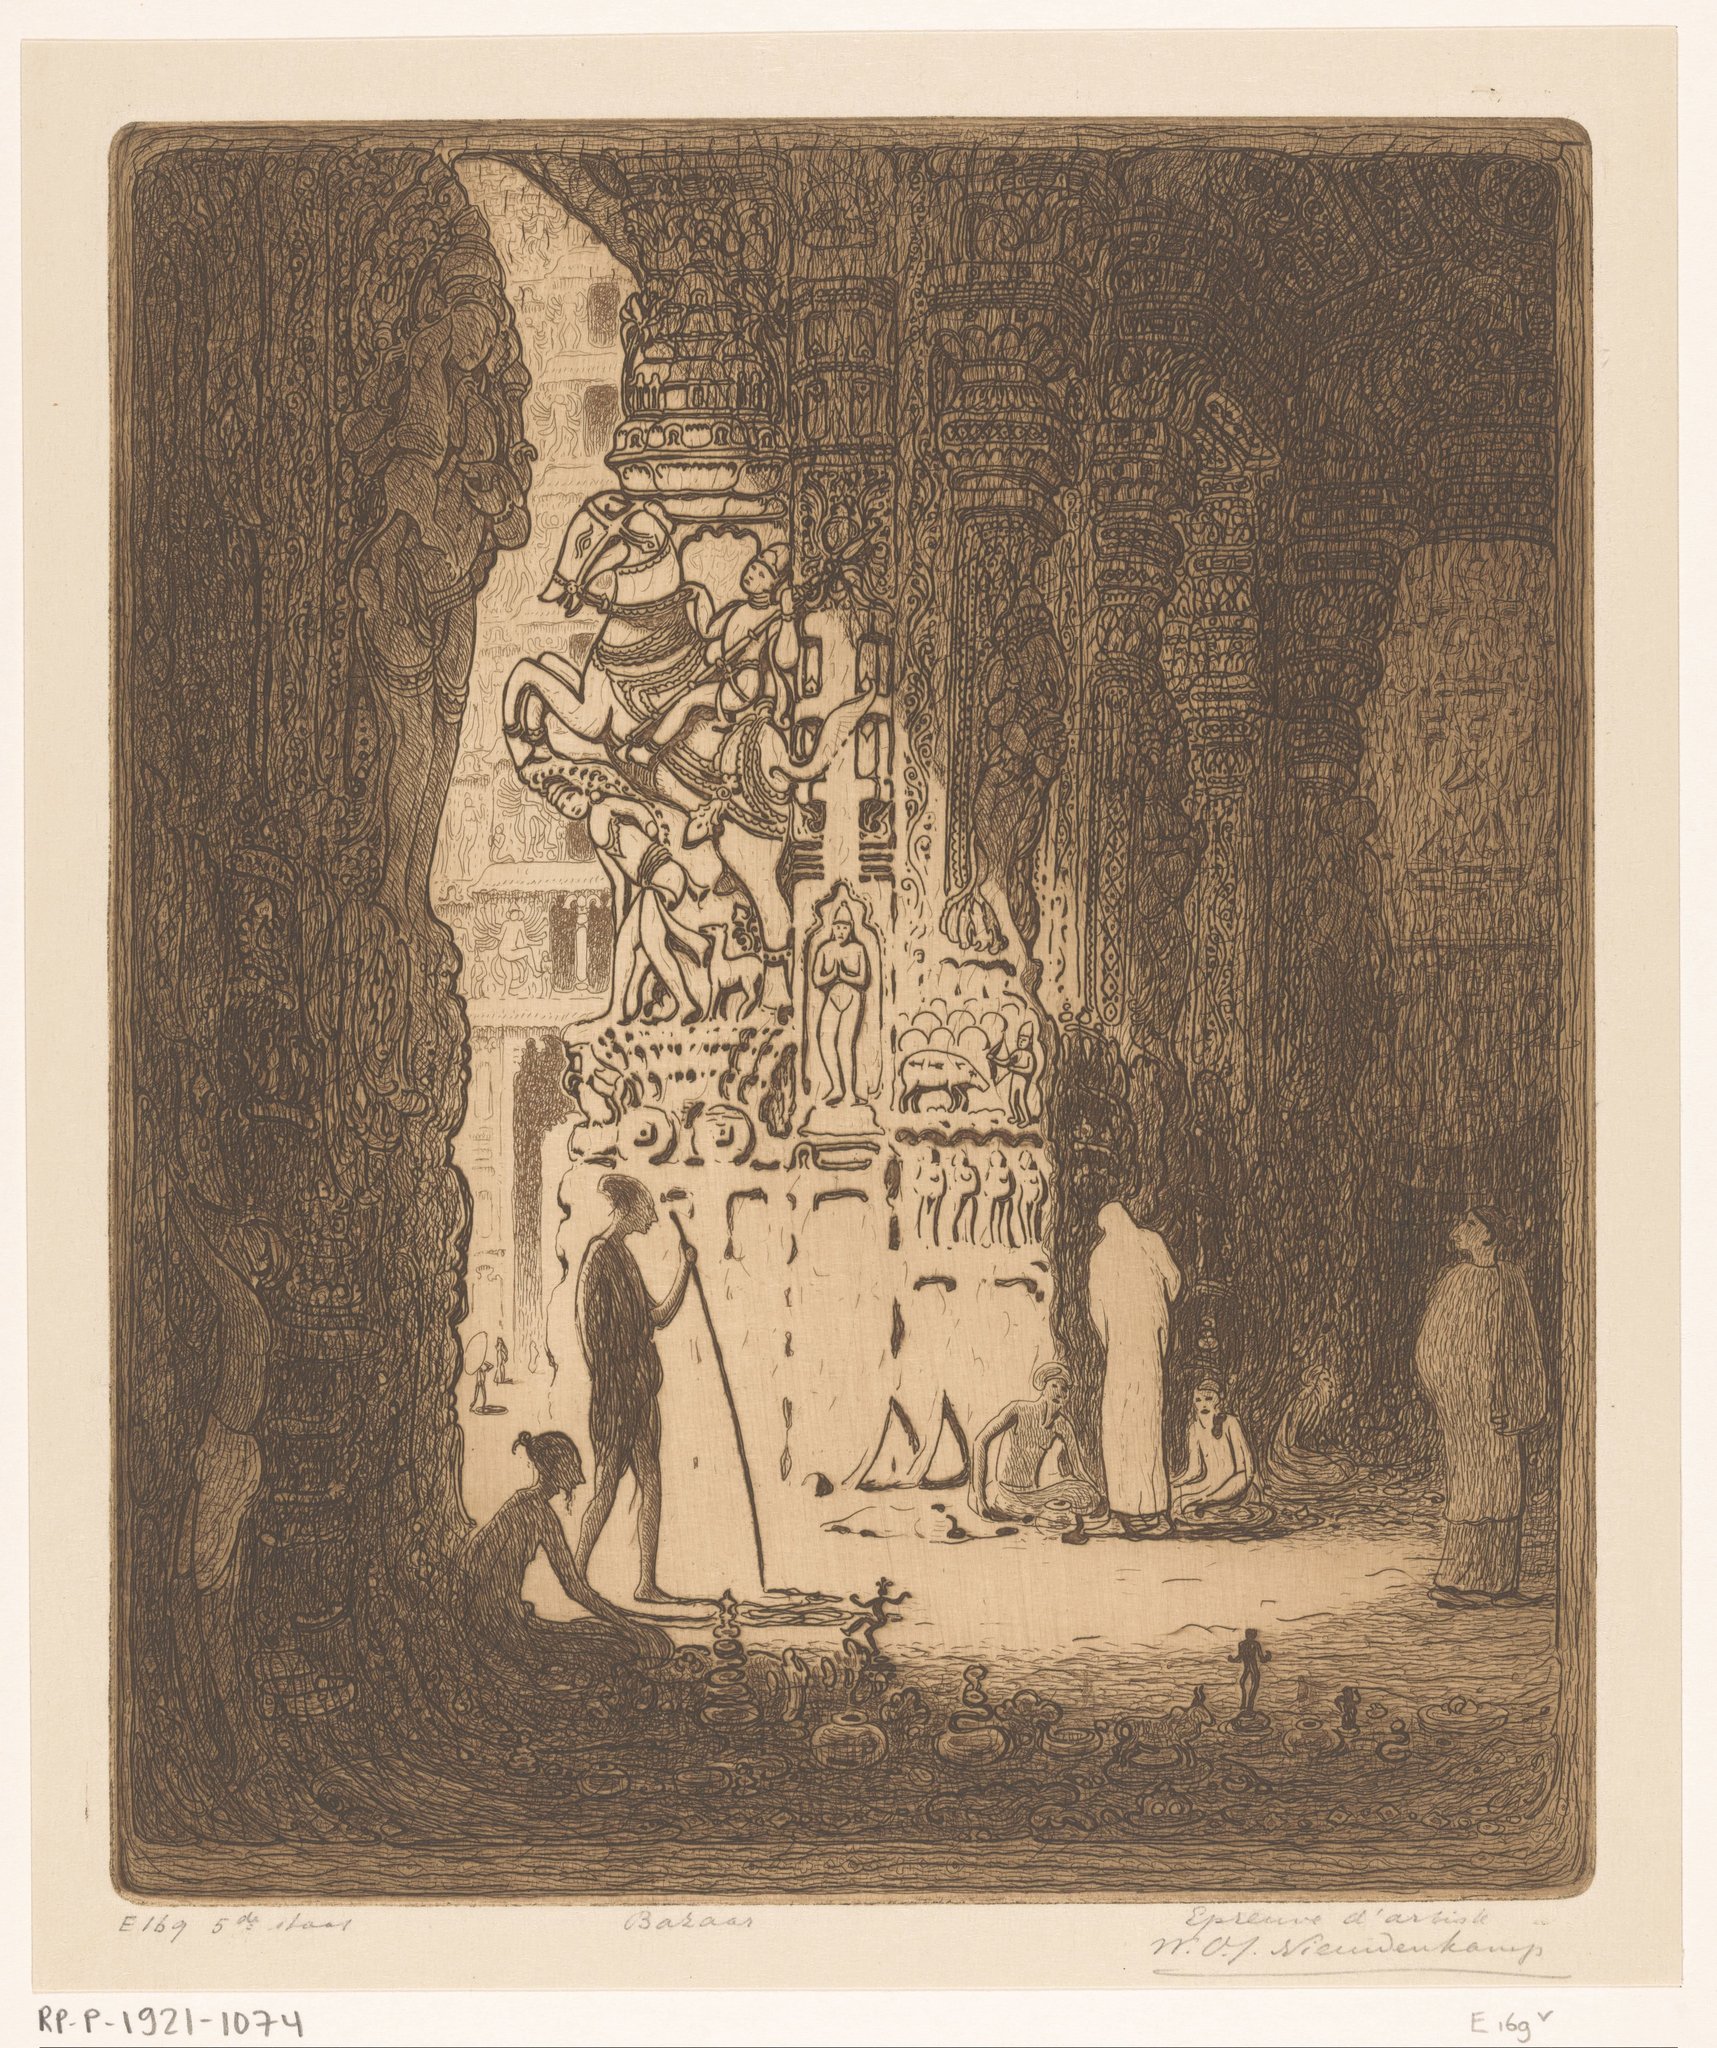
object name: print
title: Bazaar, Madura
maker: wijnand otto jan nieuwenkamp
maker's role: draughtsman, print maker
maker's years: 1874-1950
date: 1909-1915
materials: paper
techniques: etching, intaglio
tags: column, pillar ~ architecture, piece of sculpture, reproduction of a piece of sculpture, market-hall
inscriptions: collector's mark: Lugt 2233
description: Op de voorgrond een koopman, zittend te midden van koperwerk. Bij deze vijfde staat van de prent is er links op de achtergrond een tempelpoort toegevoegd.